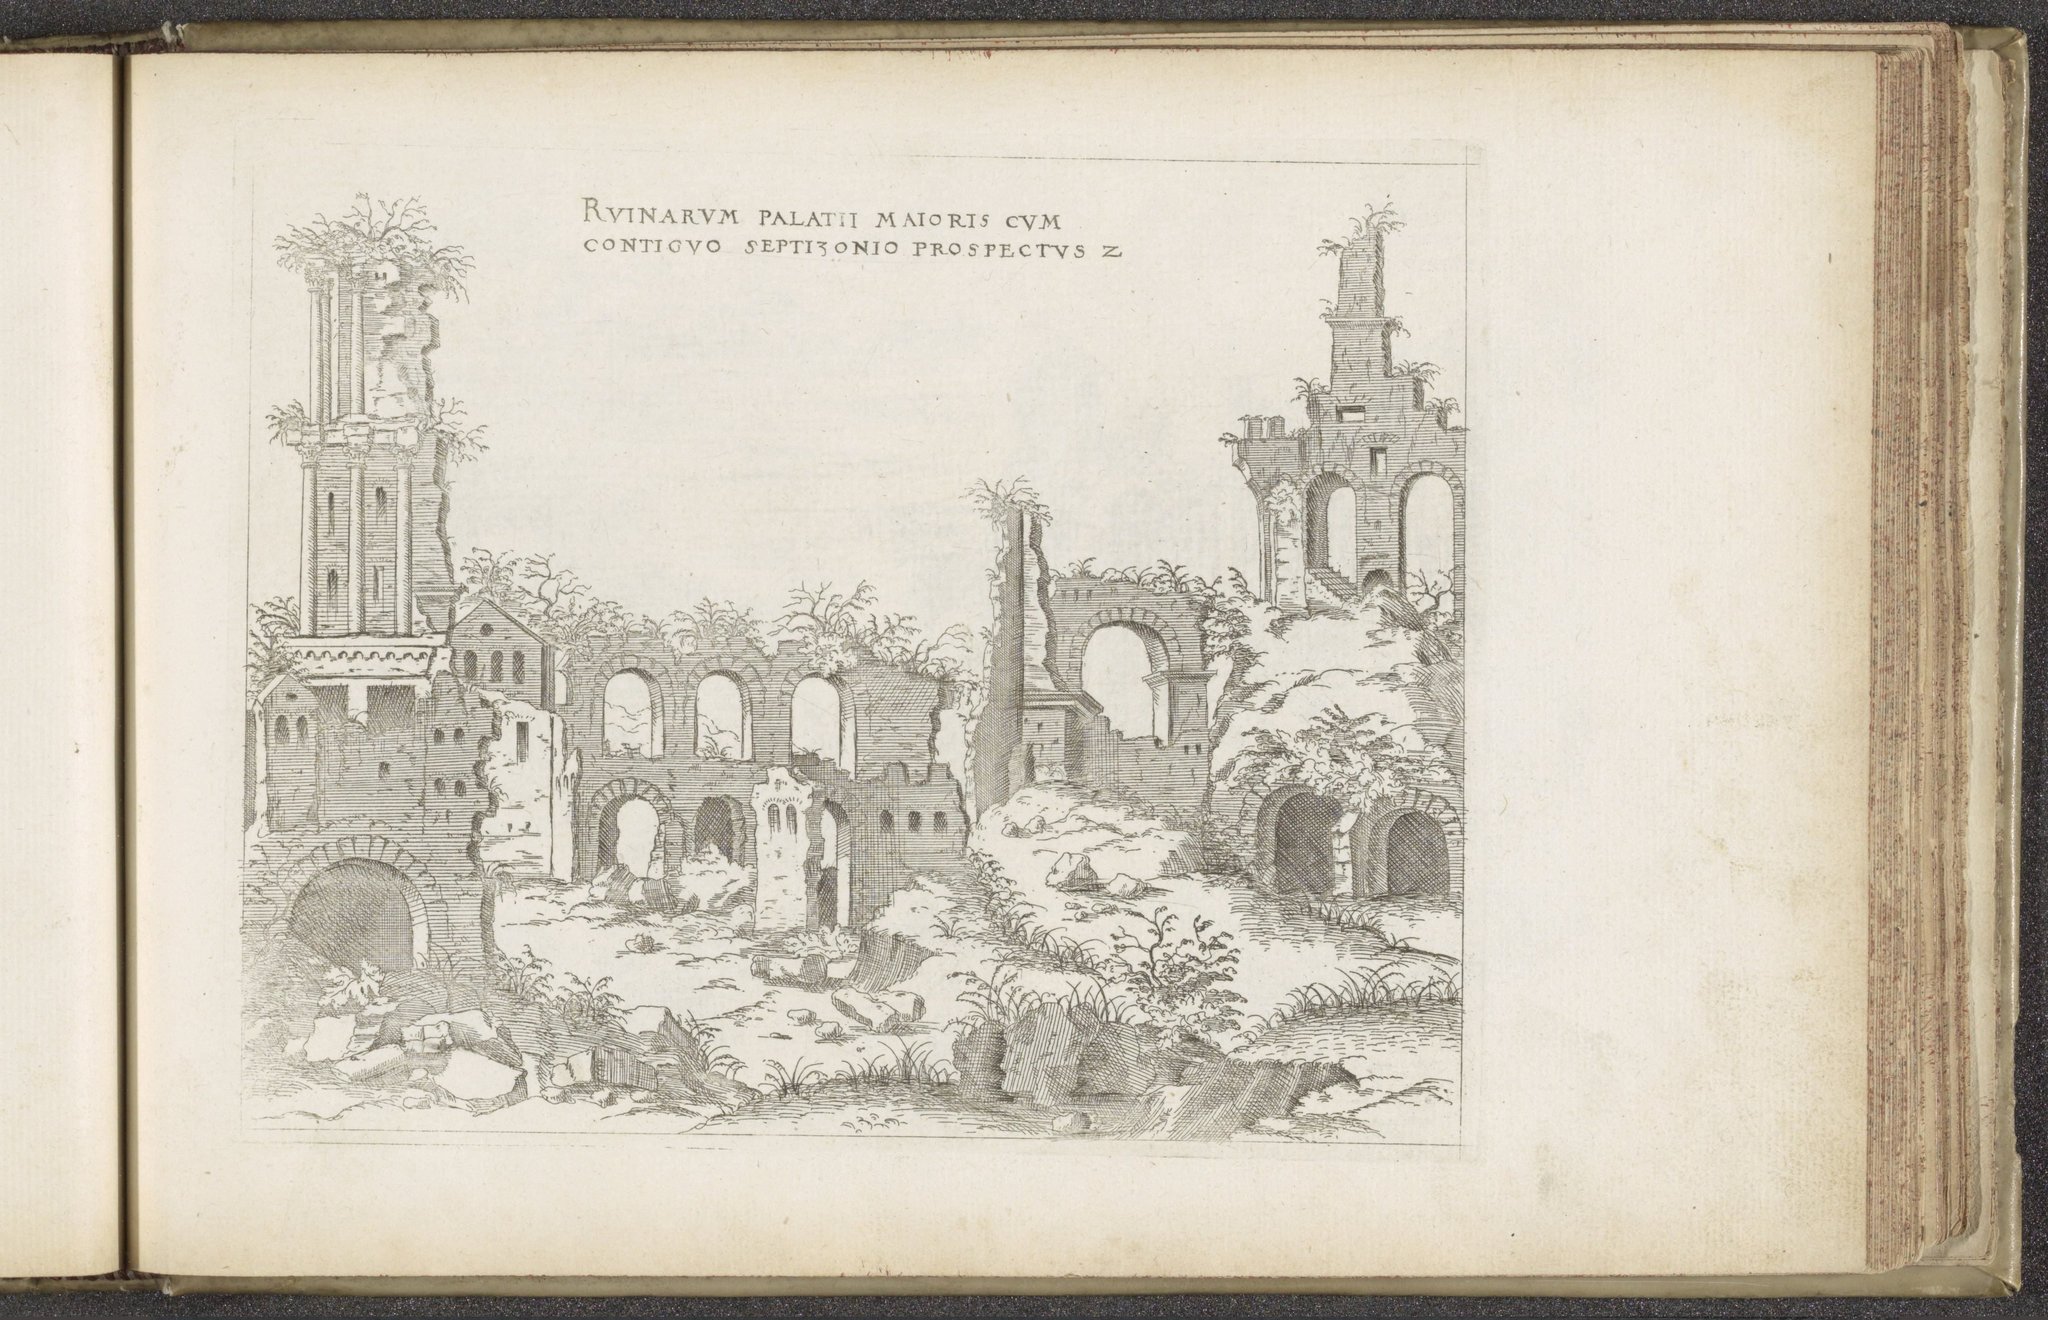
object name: print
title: Gezicht op de Palatijn met het Septizonium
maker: jacques androuet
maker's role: draughtsman, print maker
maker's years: 1515-1584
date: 1551-1584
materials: paper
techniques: etching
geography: orléans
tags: ruin of a building ~ architecture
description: Gezicht op de ruïnes op de Palatijn in Rome met links een deel van het Septizonium. Deze prent maakt deel uit van een album.